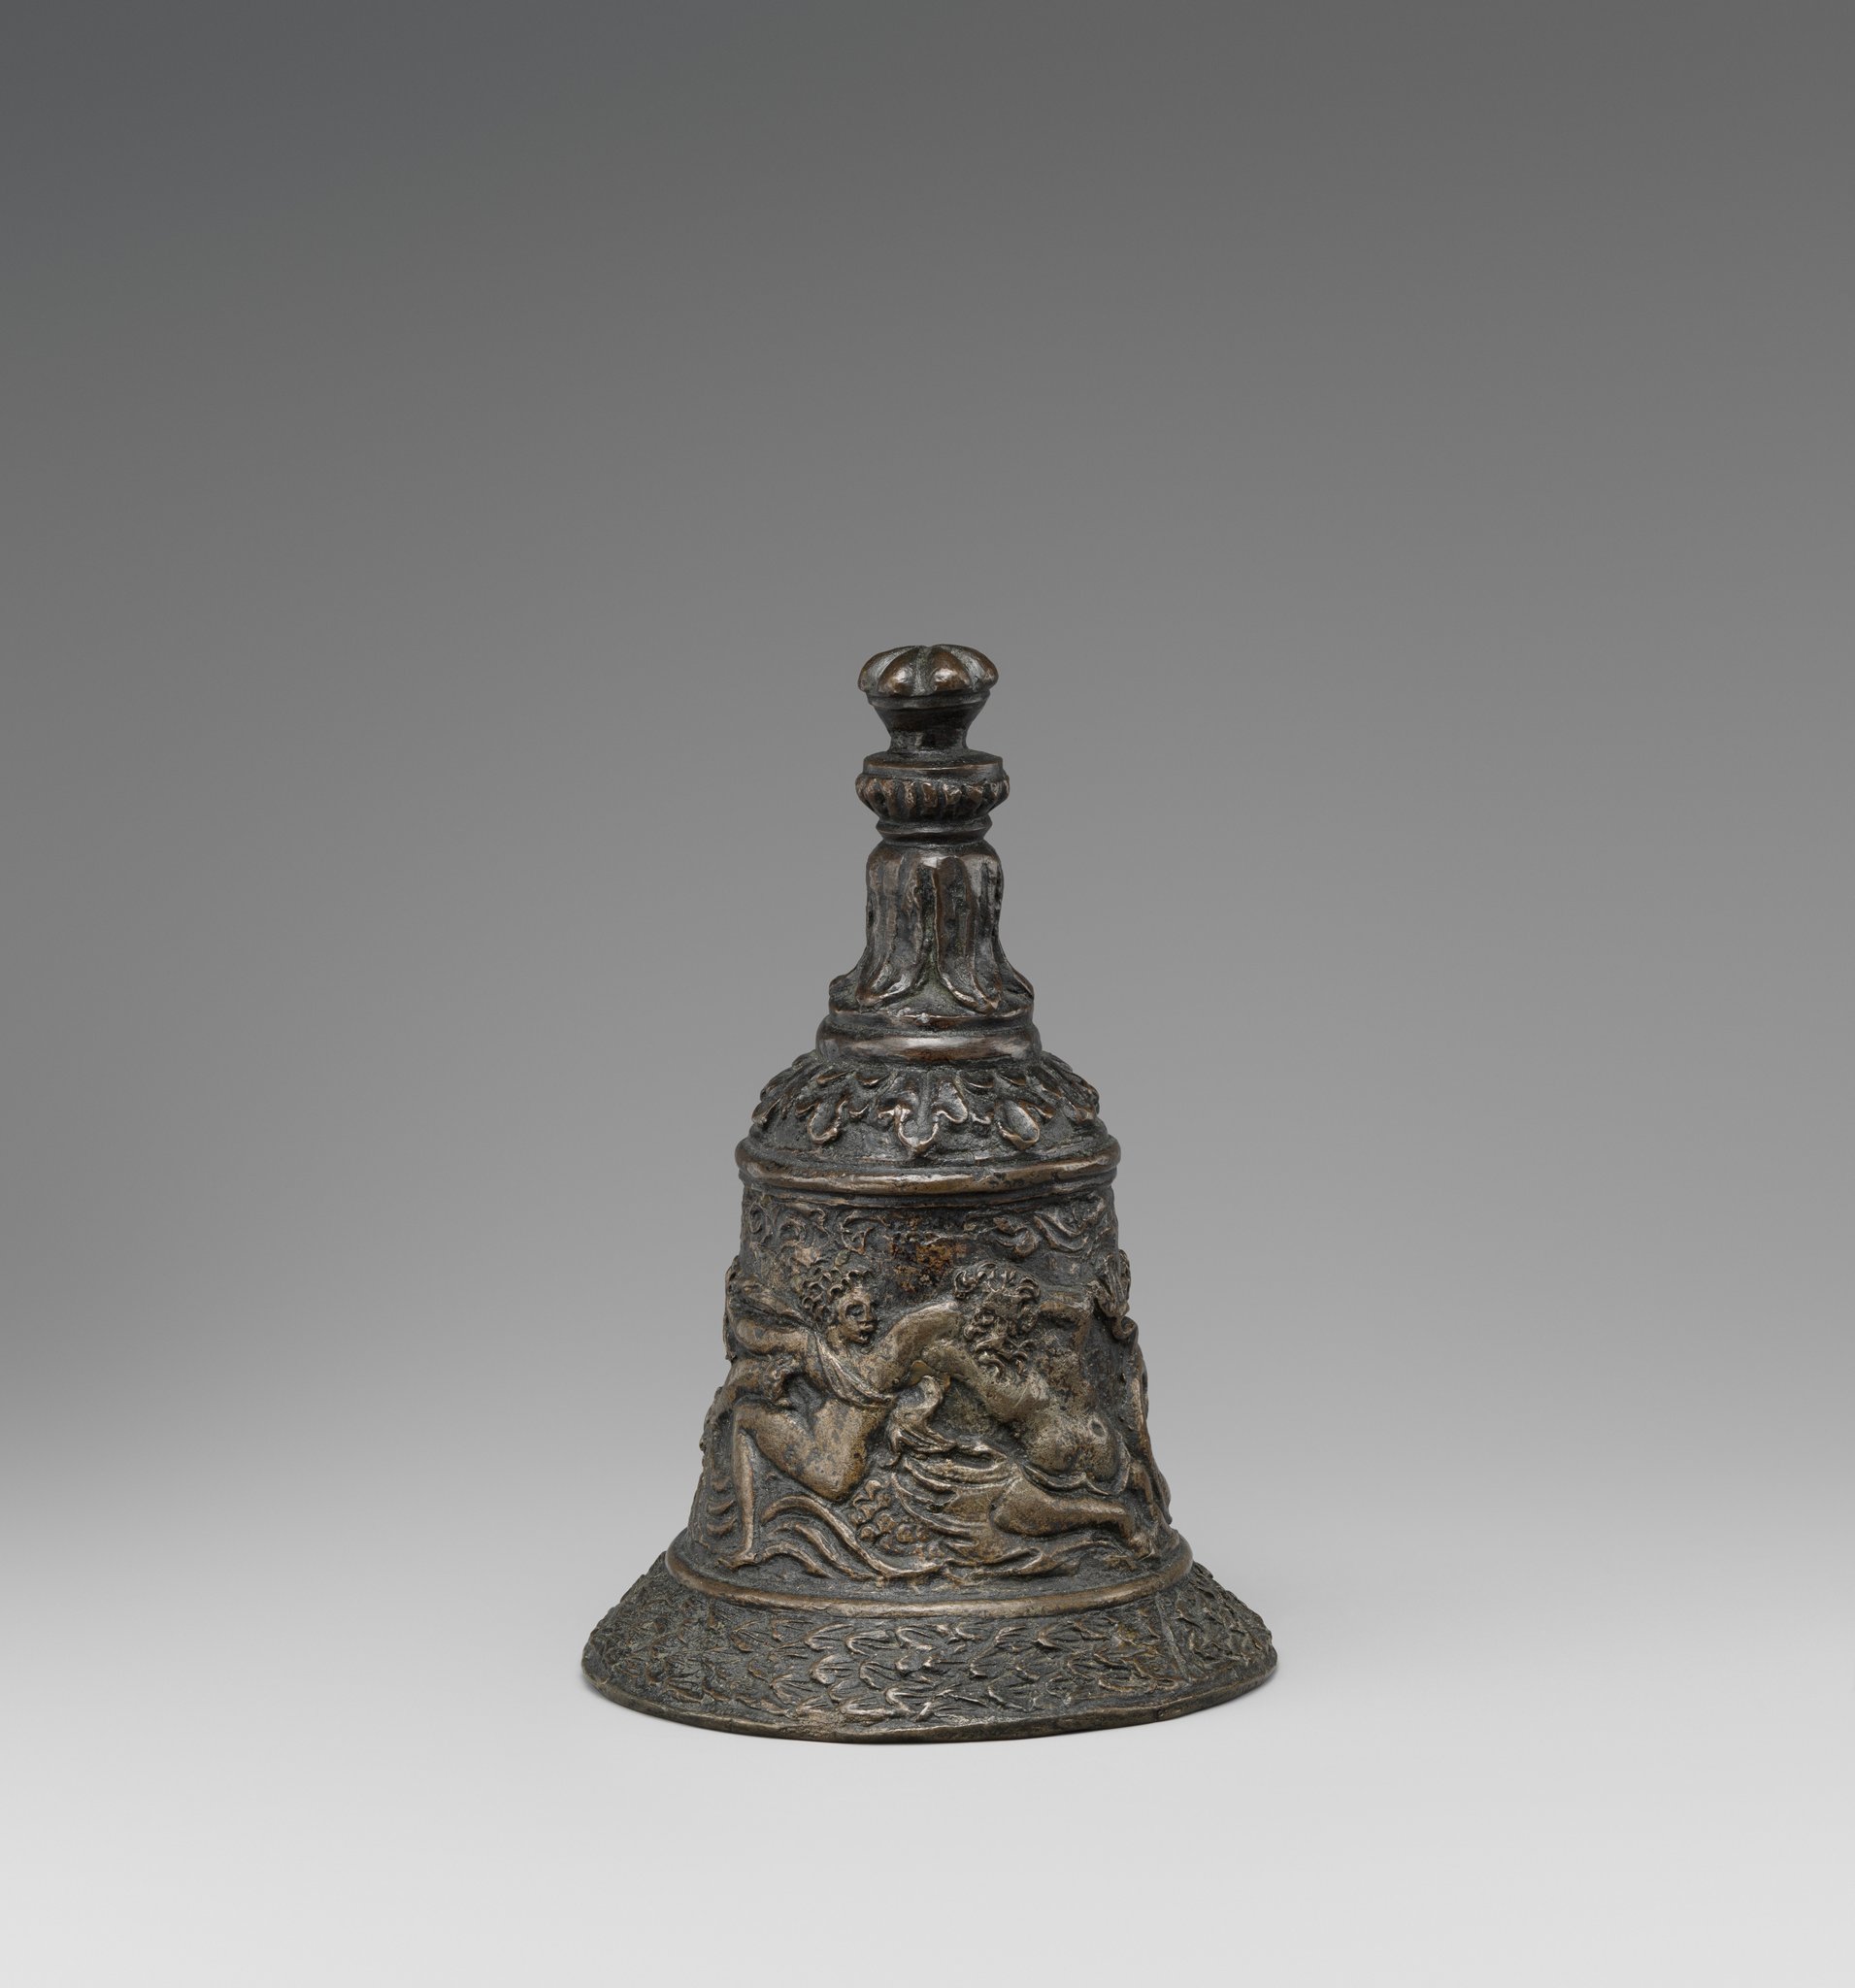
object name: bell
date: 1501-1600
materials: bronze, lacquer, patina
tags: triton,dolphins